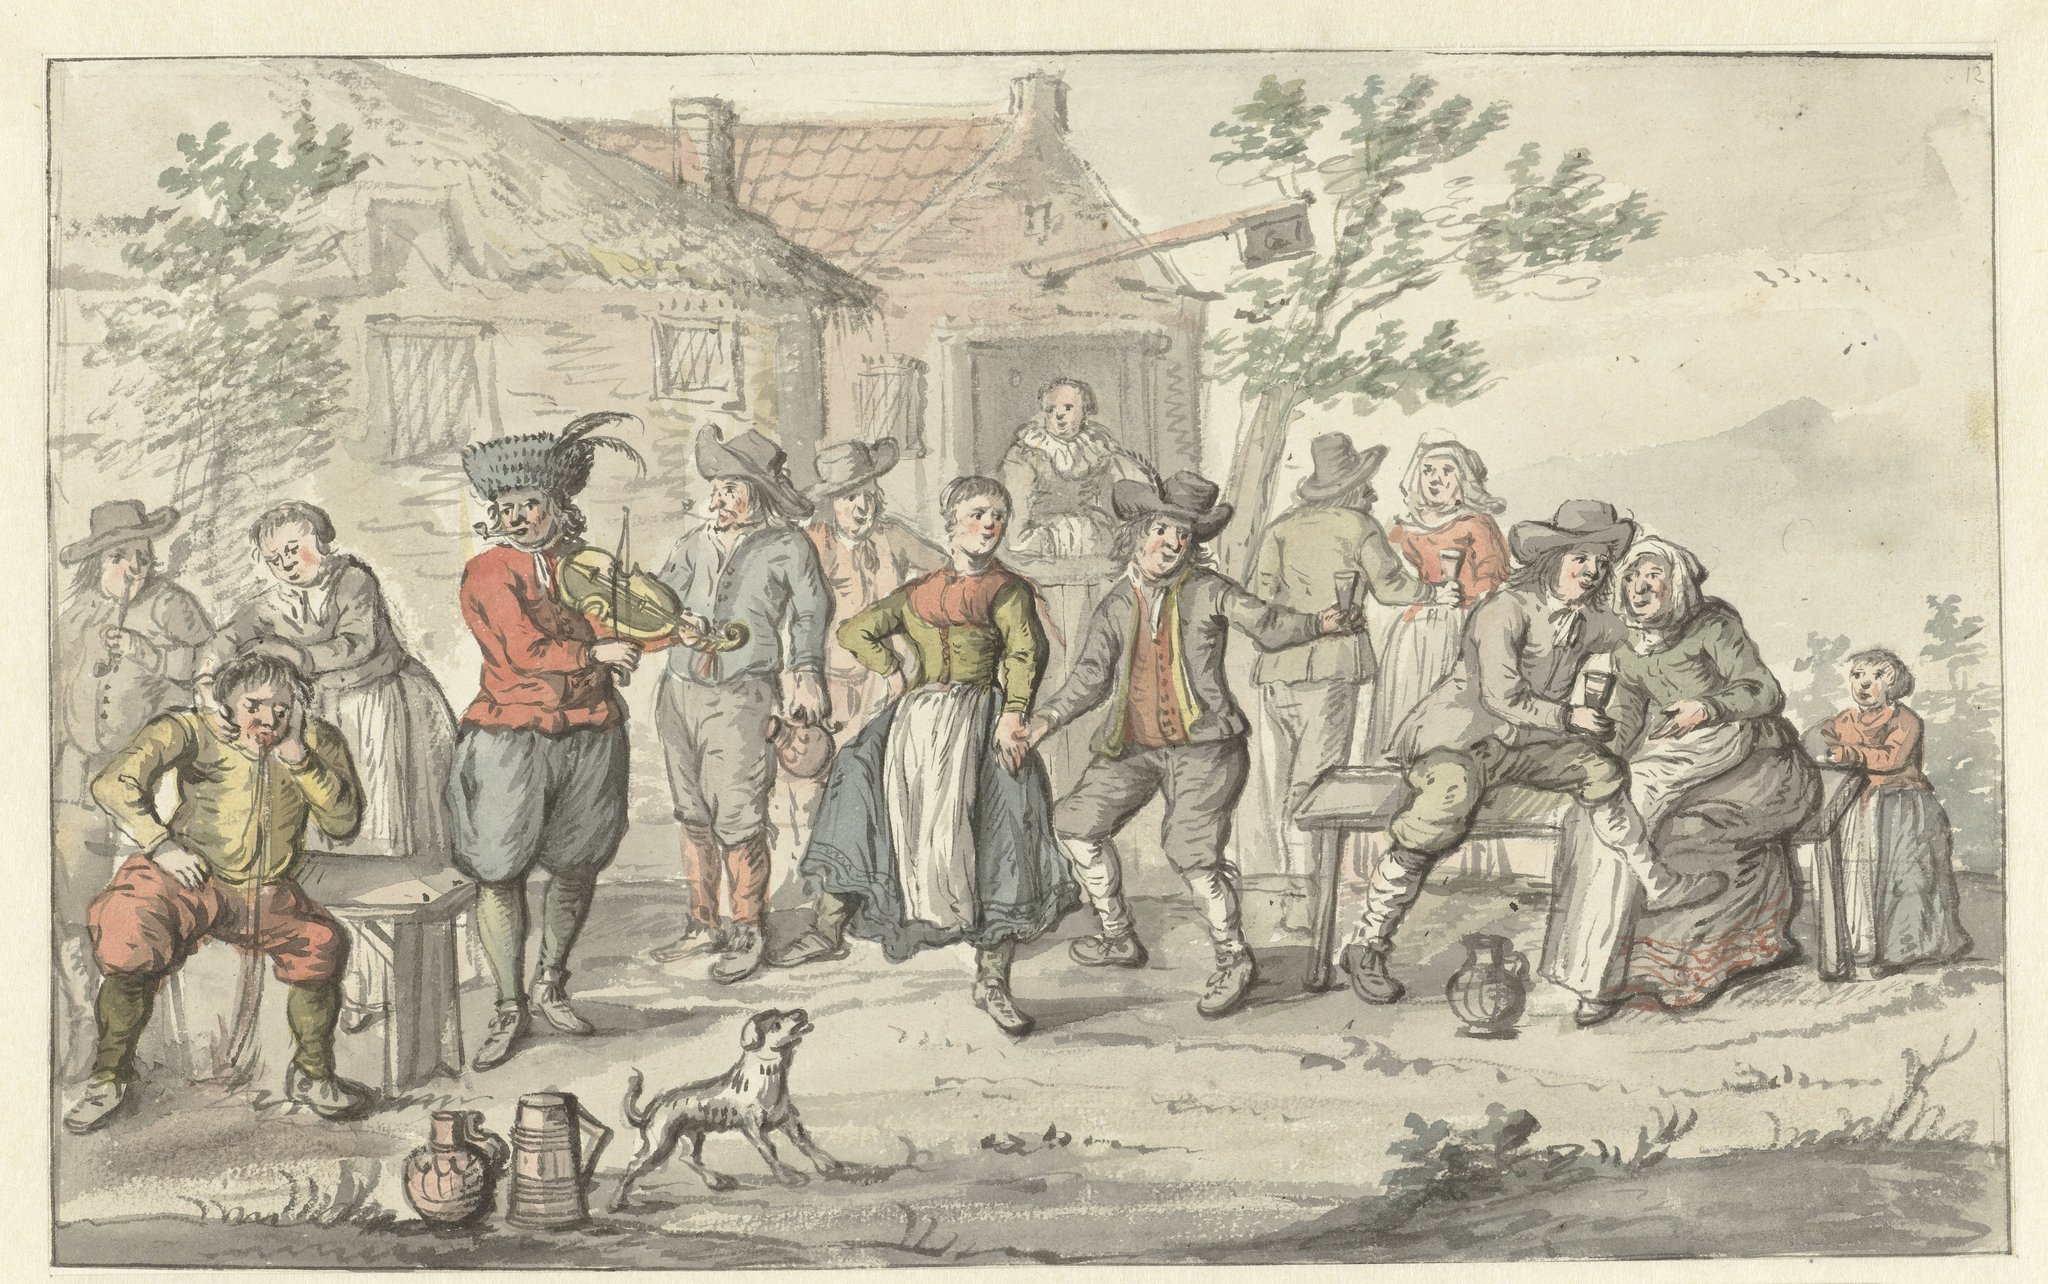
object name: drawing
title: Vrolijk gezelschap voor een herberg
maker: gerrit grasdorp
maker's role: draughtsman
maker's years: 1659-1716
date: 1661-1693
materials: ink, paper, watercolor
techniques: brush, pen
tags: vomiting, pavement, terrace in front of inn or restaurant, celebration meal, feast, banquet, one pair dancing; man and woman dancing as a couple (+ out of doors (sports, games, etc.))